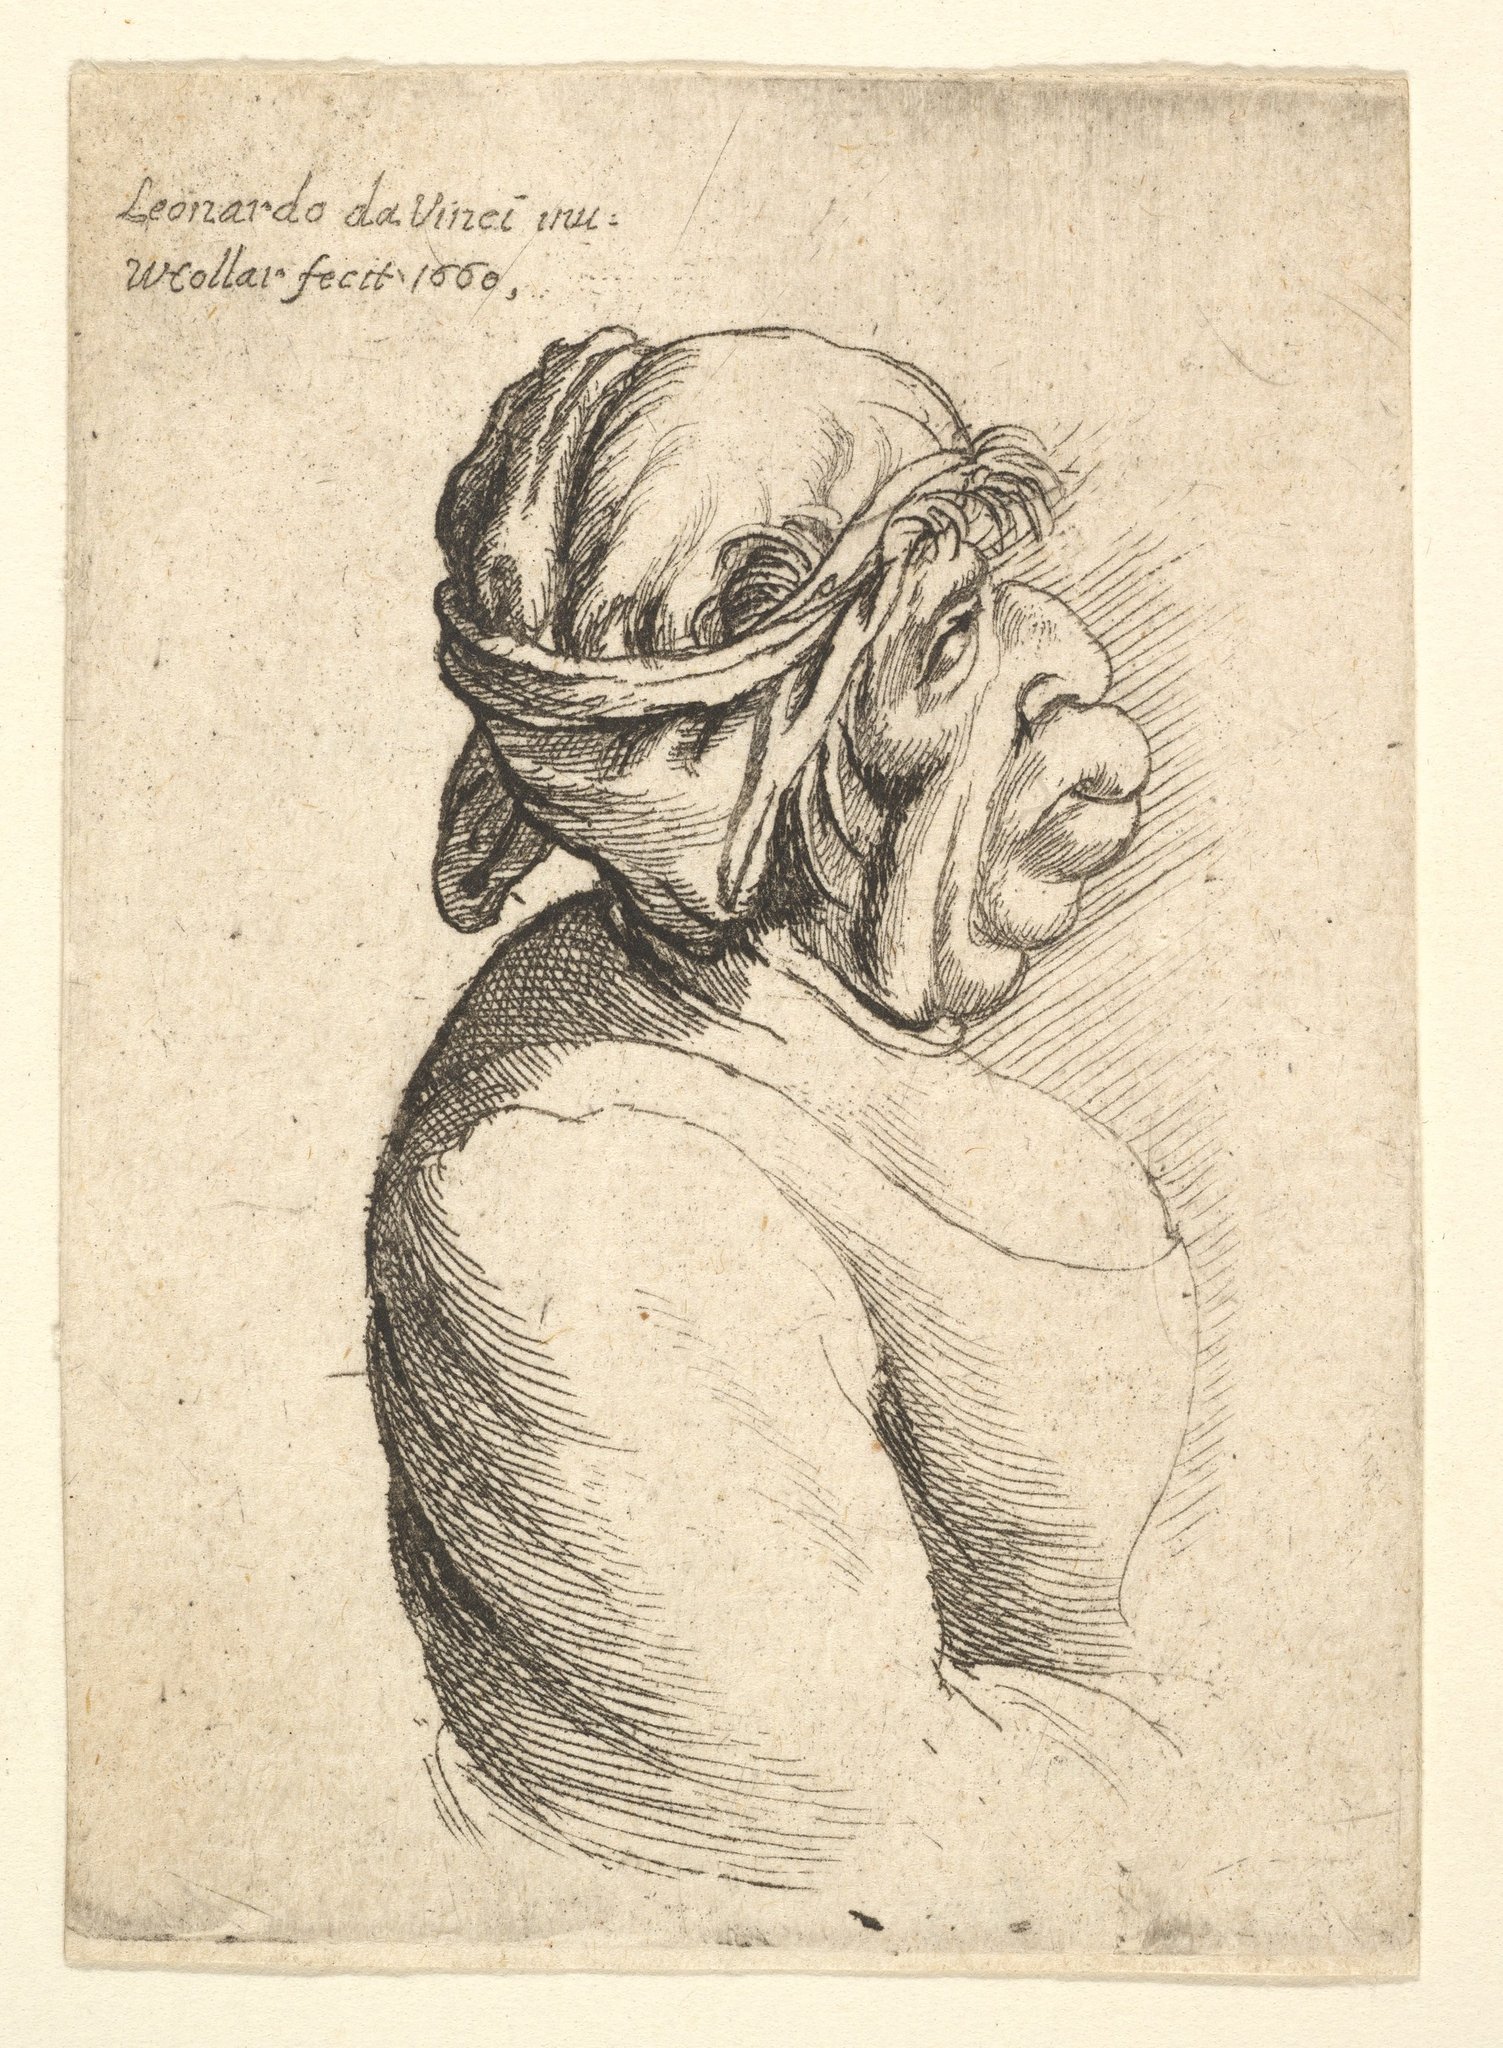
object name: print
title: Bust of woman with protruding mouth wearing low-cut dress and cloth bound around her head, in profile to right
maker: wenceslaus hollar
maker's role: artist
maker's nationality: bohemian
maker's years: 1607-1677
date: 1660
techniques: etching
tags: women